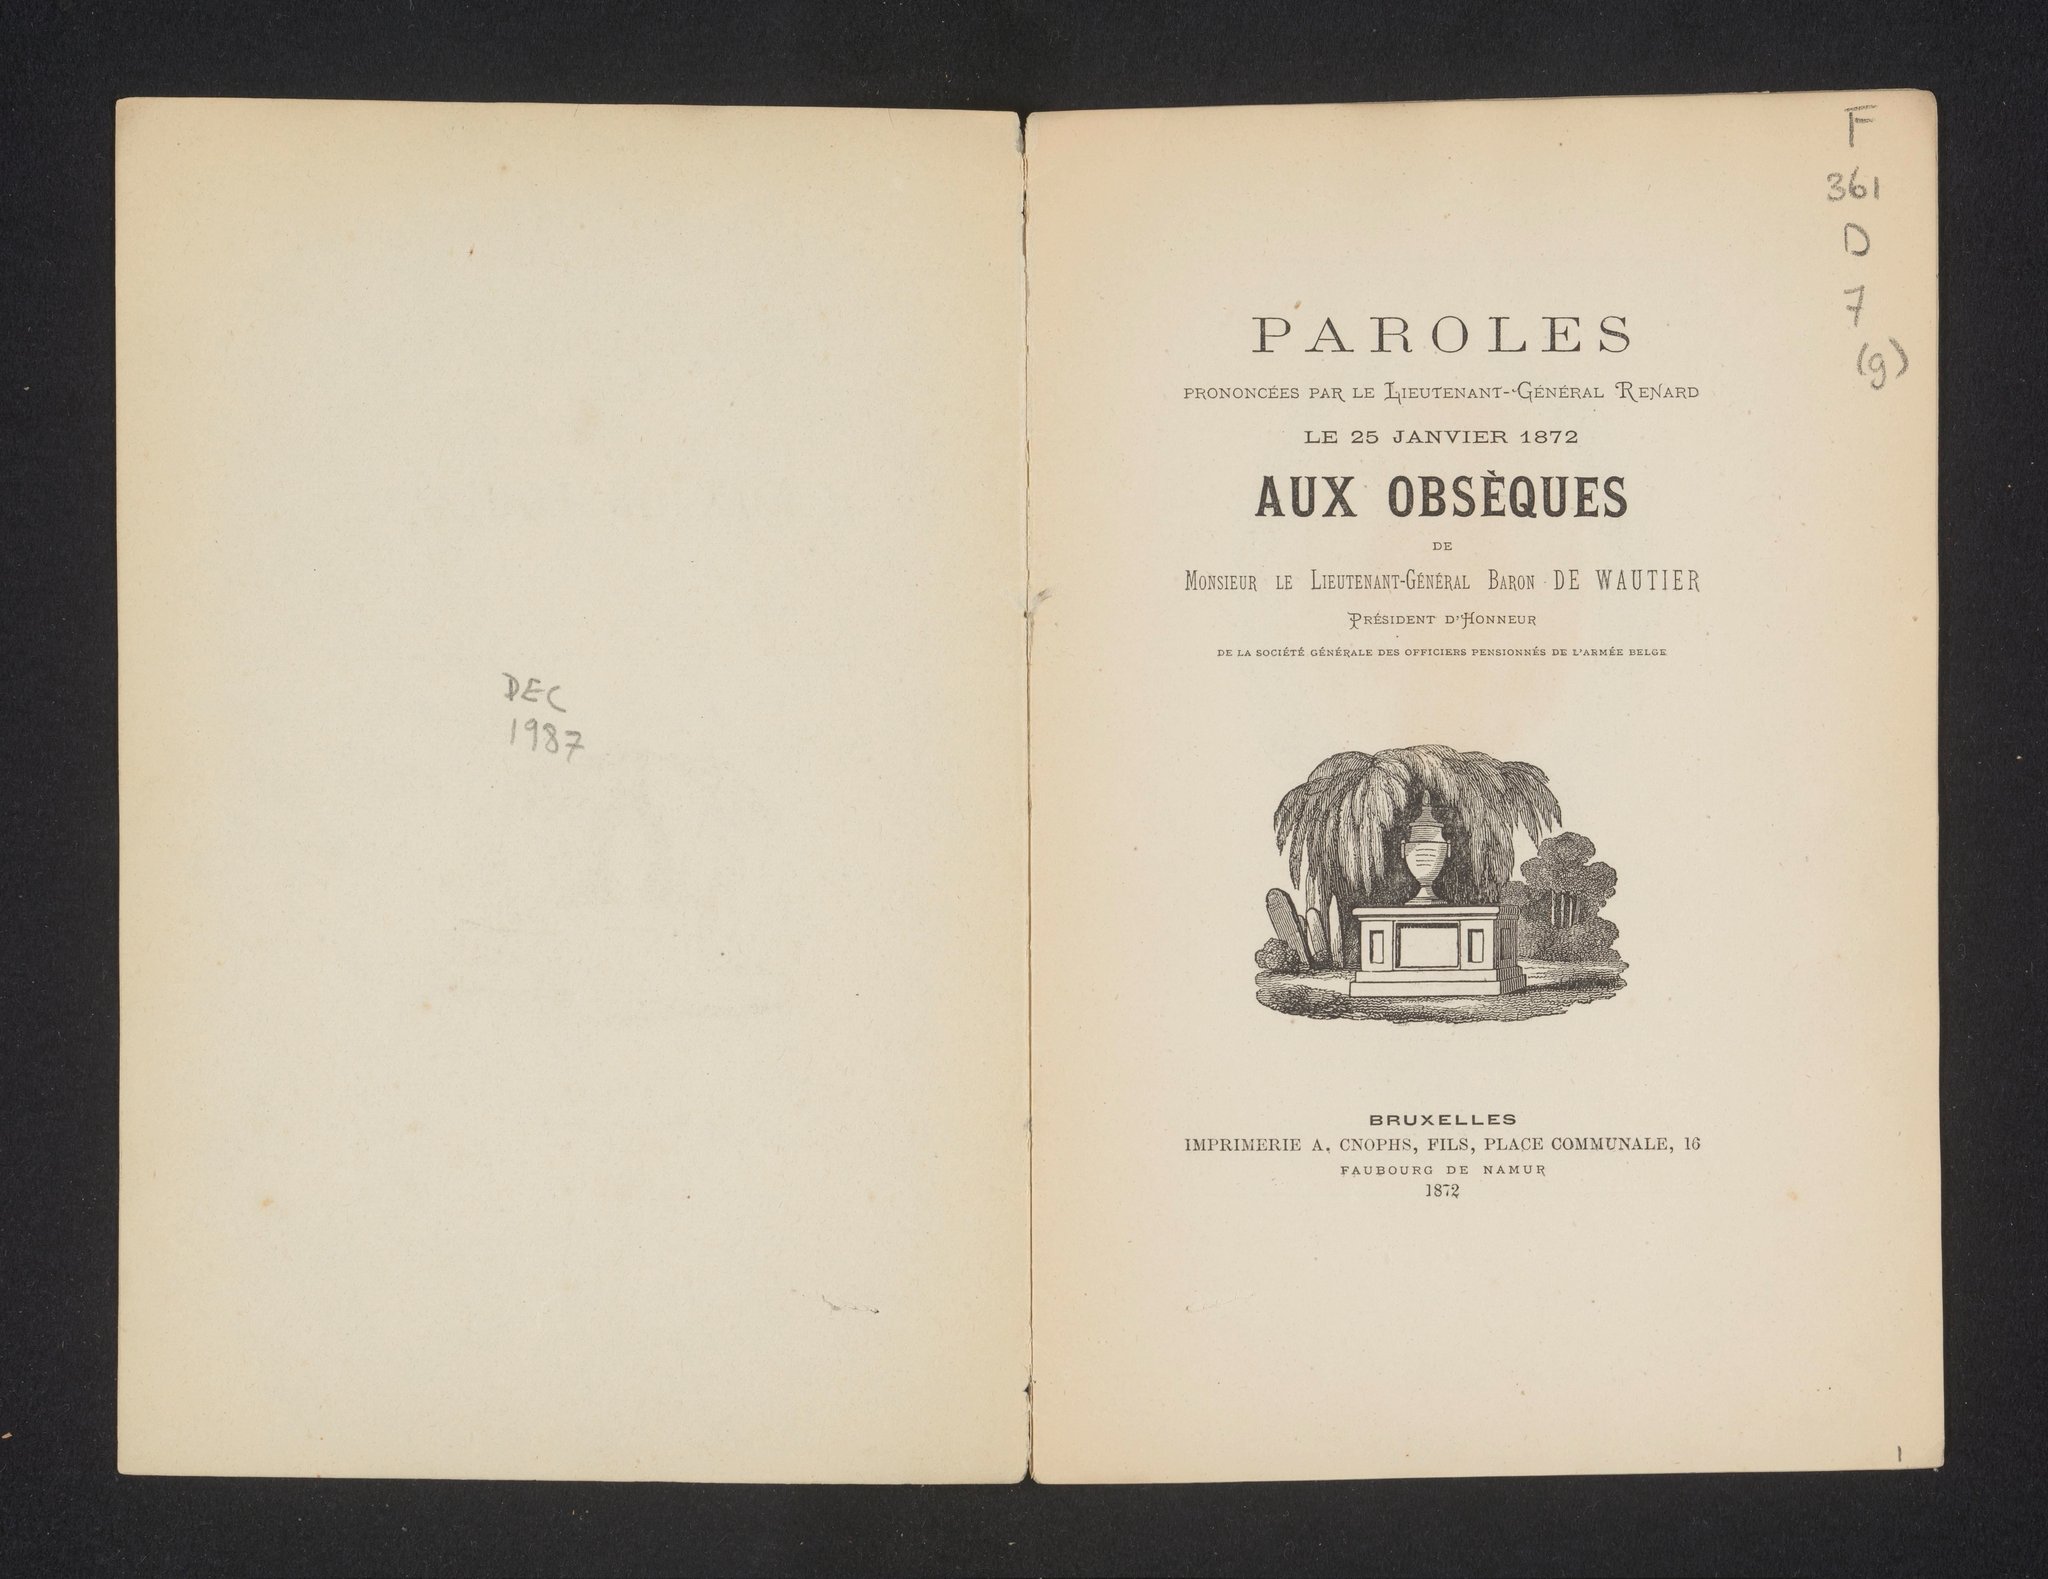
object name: book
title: Paroles prononcées par le lieutenant-général Renard, le 25 janvier 1872, aux obsèques de monsieur le lieutenant-général baron De Wautier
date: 1872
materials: paper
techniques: printing, woodburytype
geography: brussels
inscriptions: date: ‘DEC/ 1987’